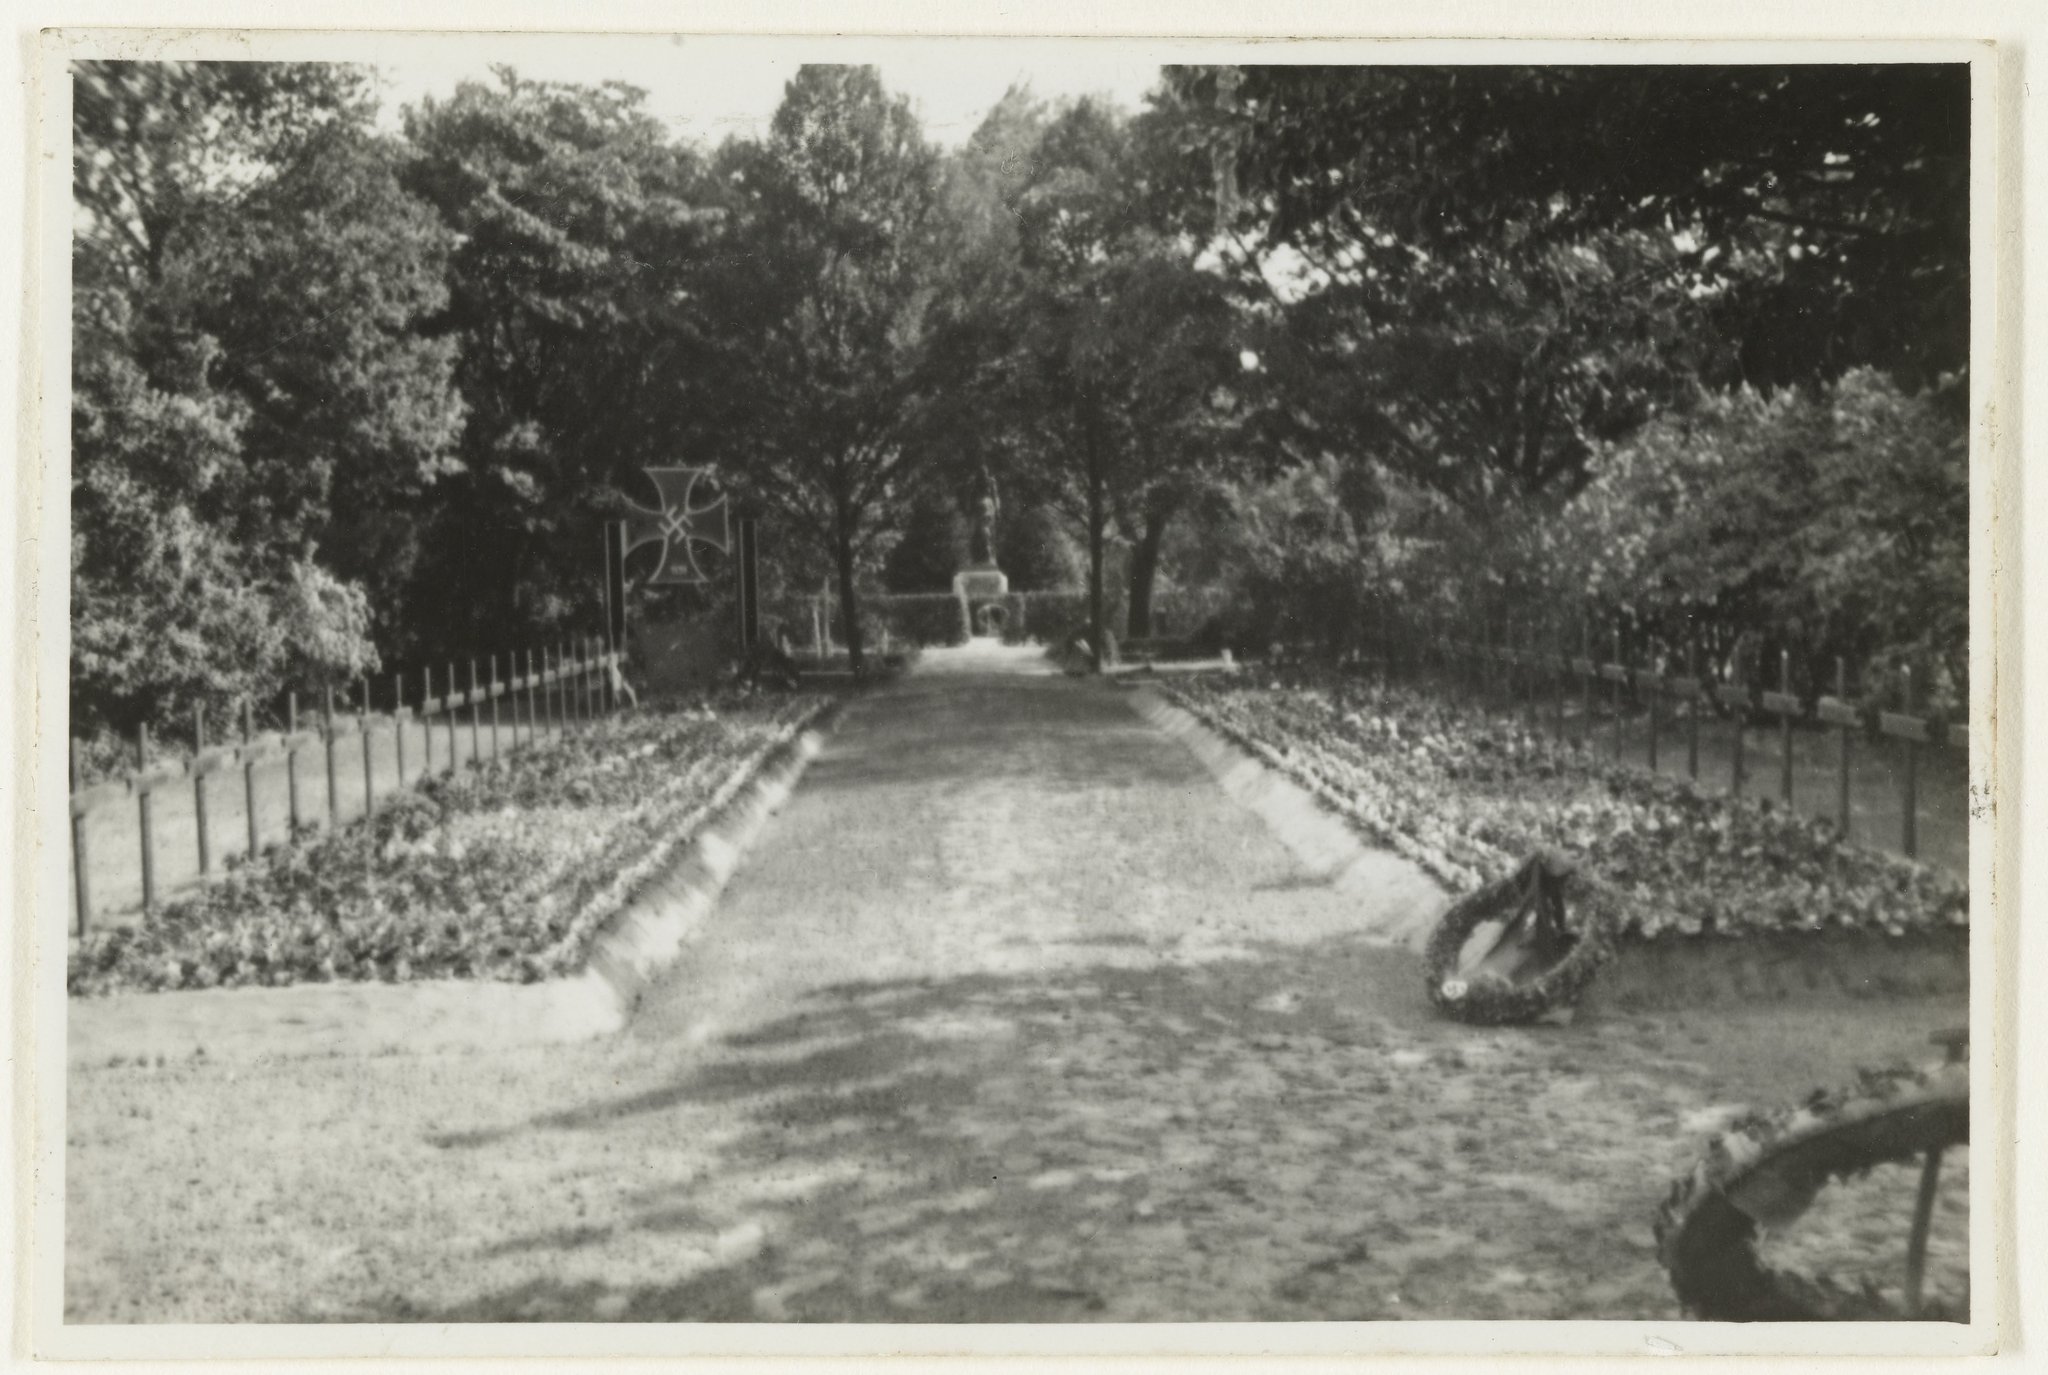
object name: photograph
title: Begraafplaats Duitse militairen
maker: Anonymous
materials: photographic support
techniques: gelatin silver print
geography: rotterdam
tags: churchyard, cemetery, occupation ~ war, grave, tomb and other grave-forms and grave-markers, rotterdam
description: Een begraafplaats met Duitse militairen, Crooswijk. Lange rijen met graven, rechts twee kransen.